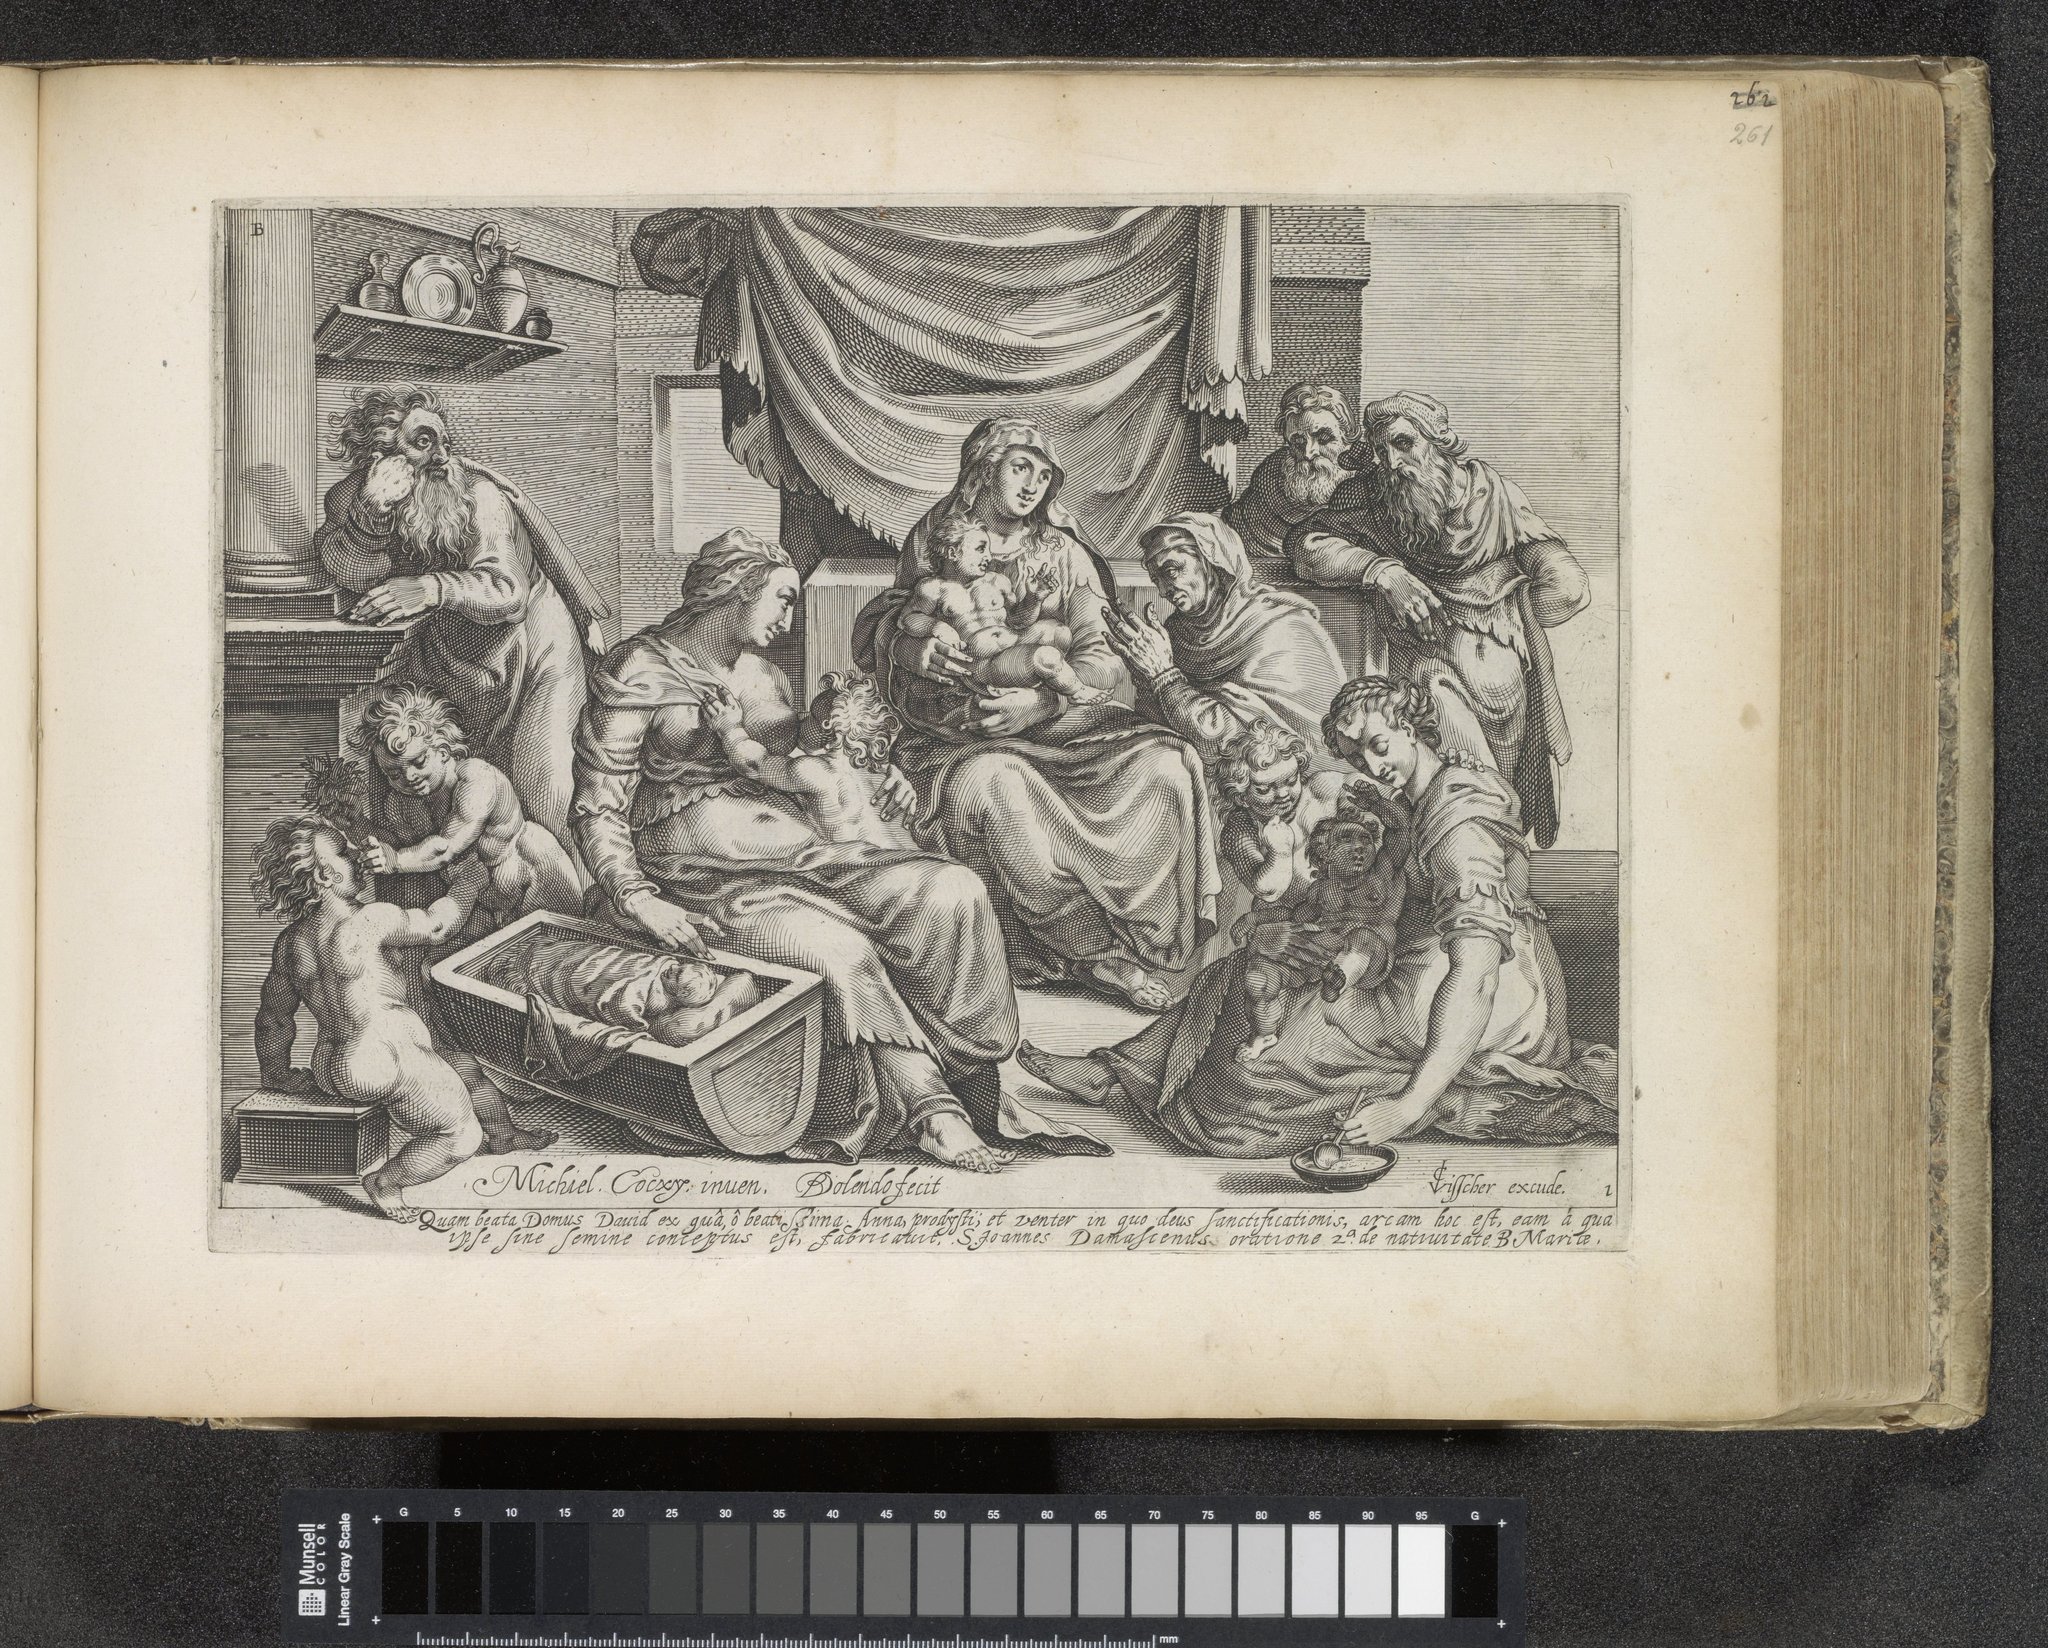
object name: album leaf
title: Heilige Familie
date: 1589-1626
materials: paper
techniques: engraving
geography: amsterdam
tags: holy family, and derived representations, holy kinship, extended representations of 'anna selbdritt' (joseph and joachim, three husbands, three daughters with seven children)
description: De Heilige Familie met de heilige Anna en andere vrouwen, mannen en kinderen in een huiskamer. Maria zit in het midden met het Christuskind op haar schoot. Anna aanbidt het Kind. Twee andere vrouwen met kleine kinderen zitten aan weerszijden van Maria. Jozef leunt links tegen een pilaar. Onder de voorstelling een tekst in het Latijn. Deze prent maakt deel uit van een album.